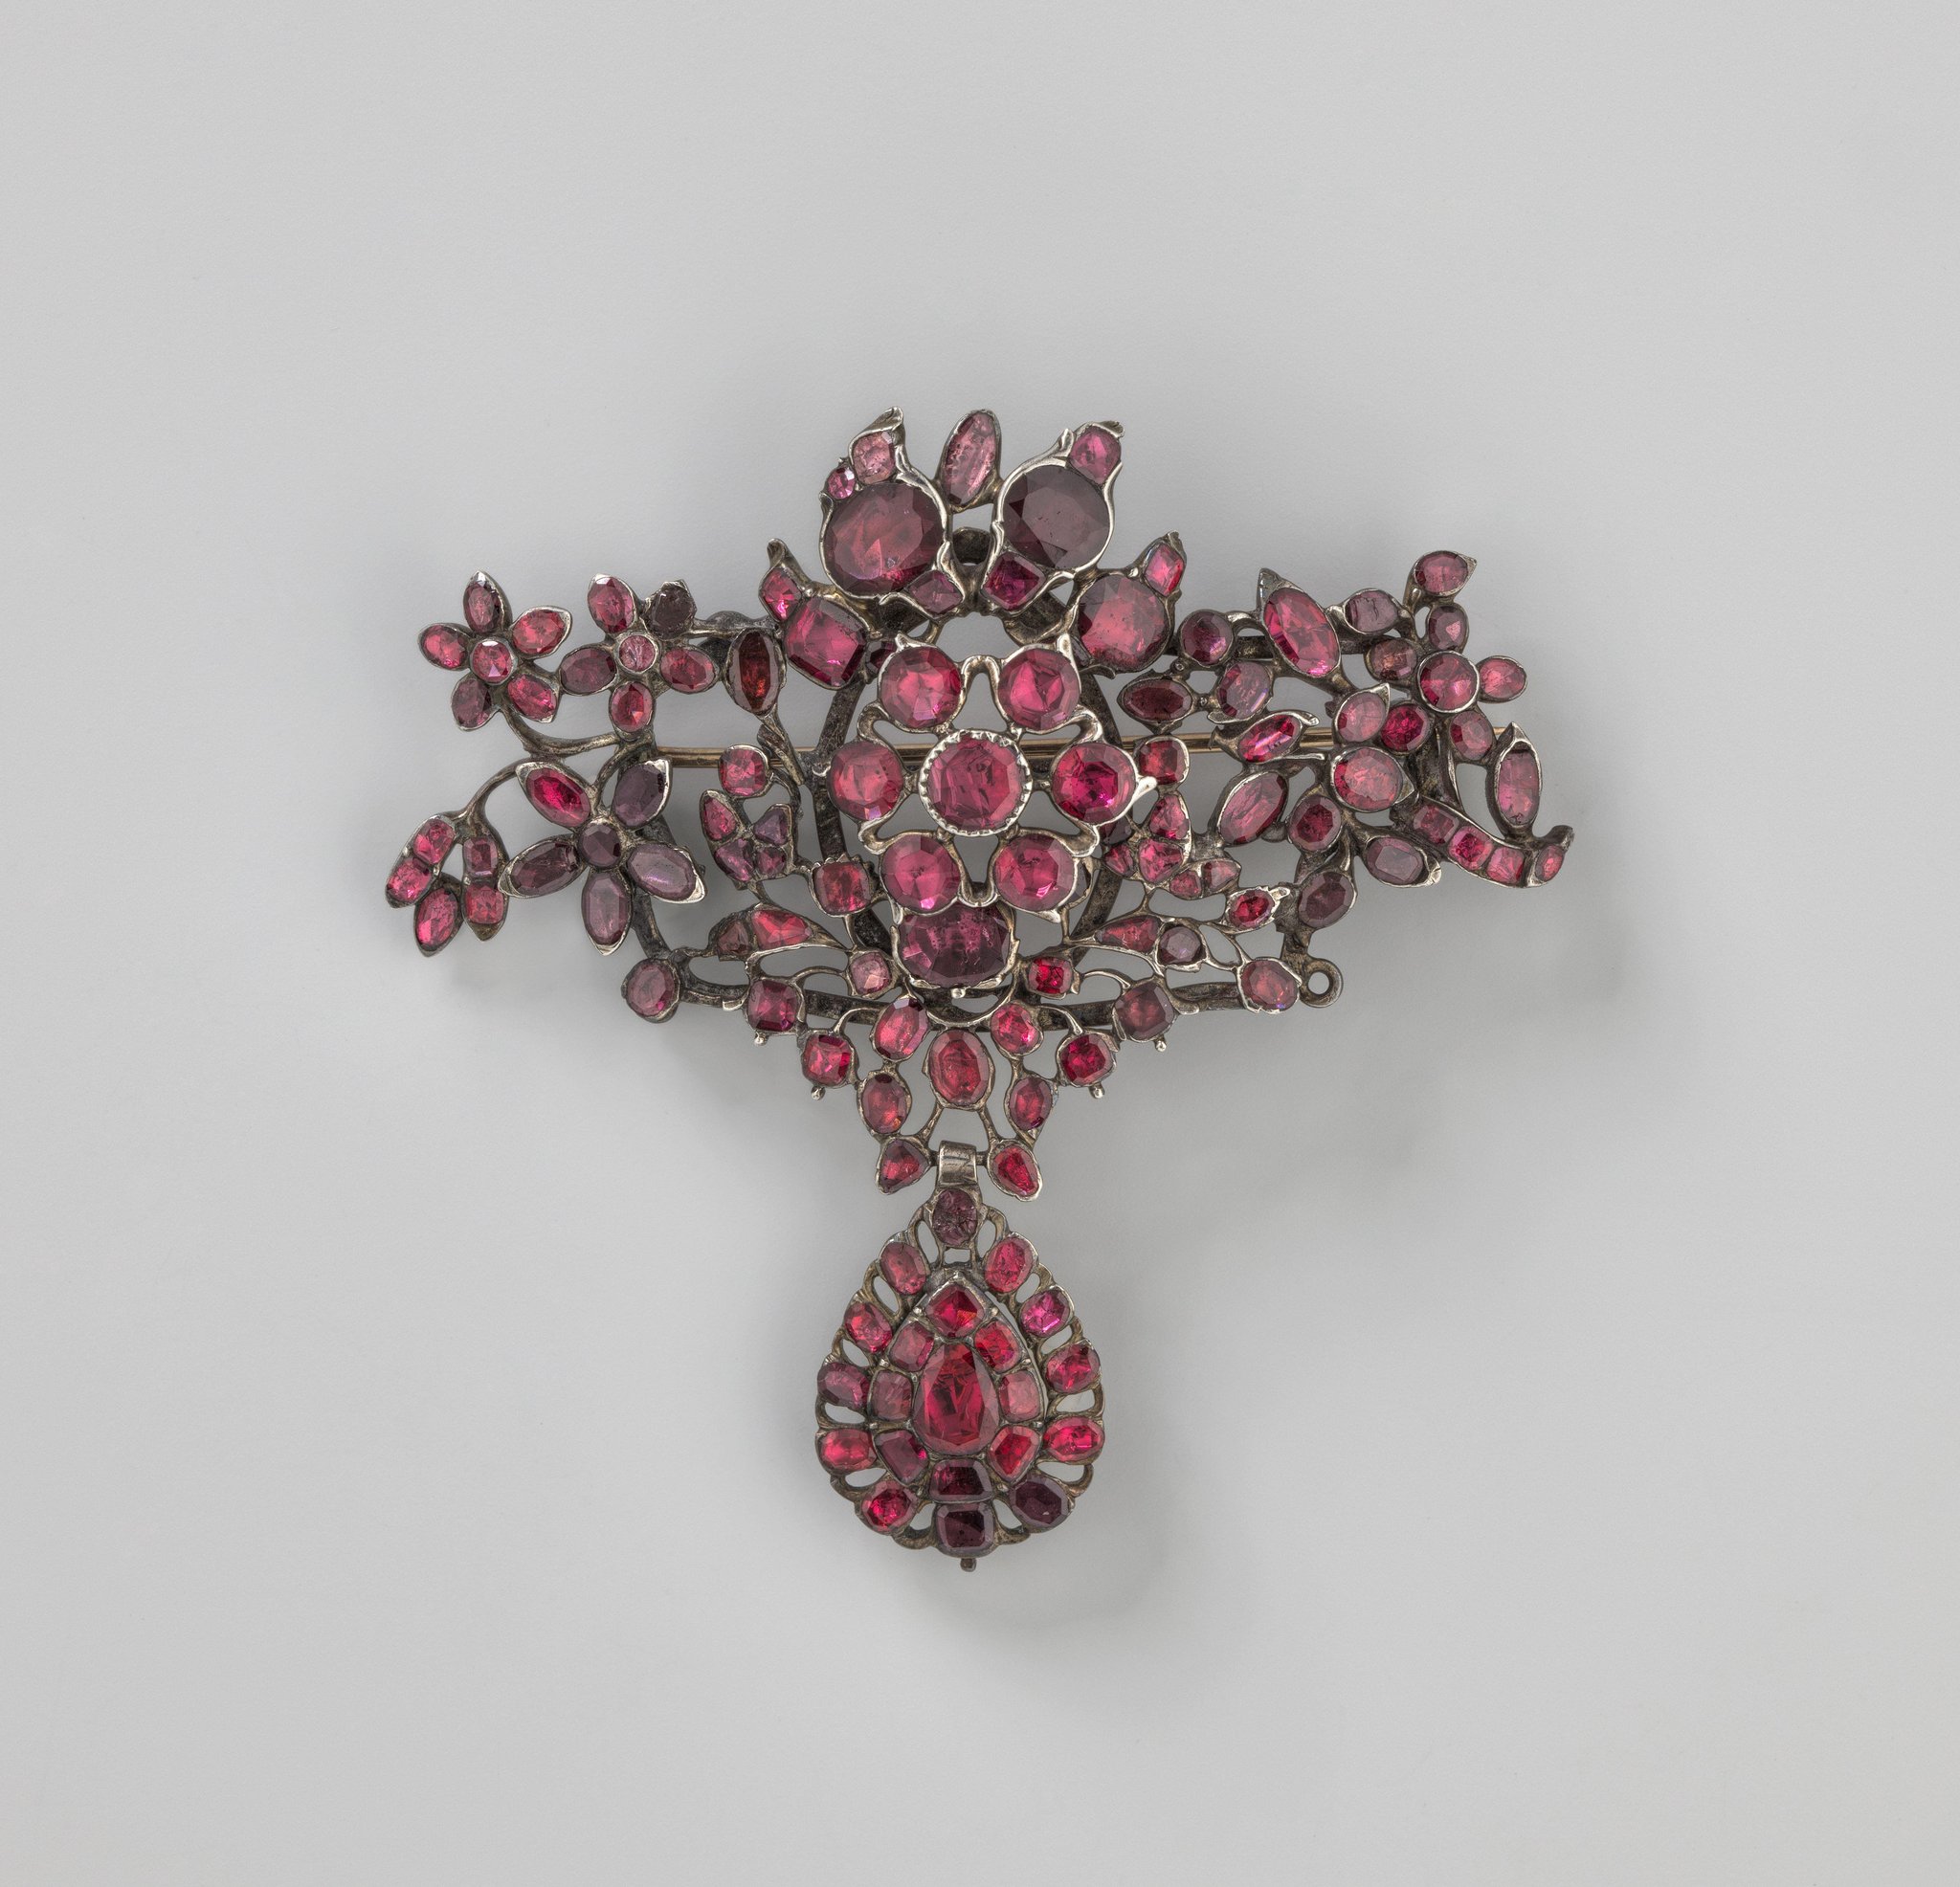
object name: brooch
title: Broche in floraal motief met druppelvormige hanger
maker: Anonymous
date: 1770-1790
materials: gemstone, silver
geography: england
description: Broche van zilver en granaten in floraal motief met druppelvormige hanger. De granaten zijn op zilverfolie gezet. Waarschijnlijk ontbreken er twee druppelvormige hangers welke van weerszijden van de centrale hanger bevestigd waren. Aan de achterzijde van de broche zijn twee oogjes zichtbaar waarmee de broche aan kleding kon worden vastgezet. De haakbrochering is van later datum.